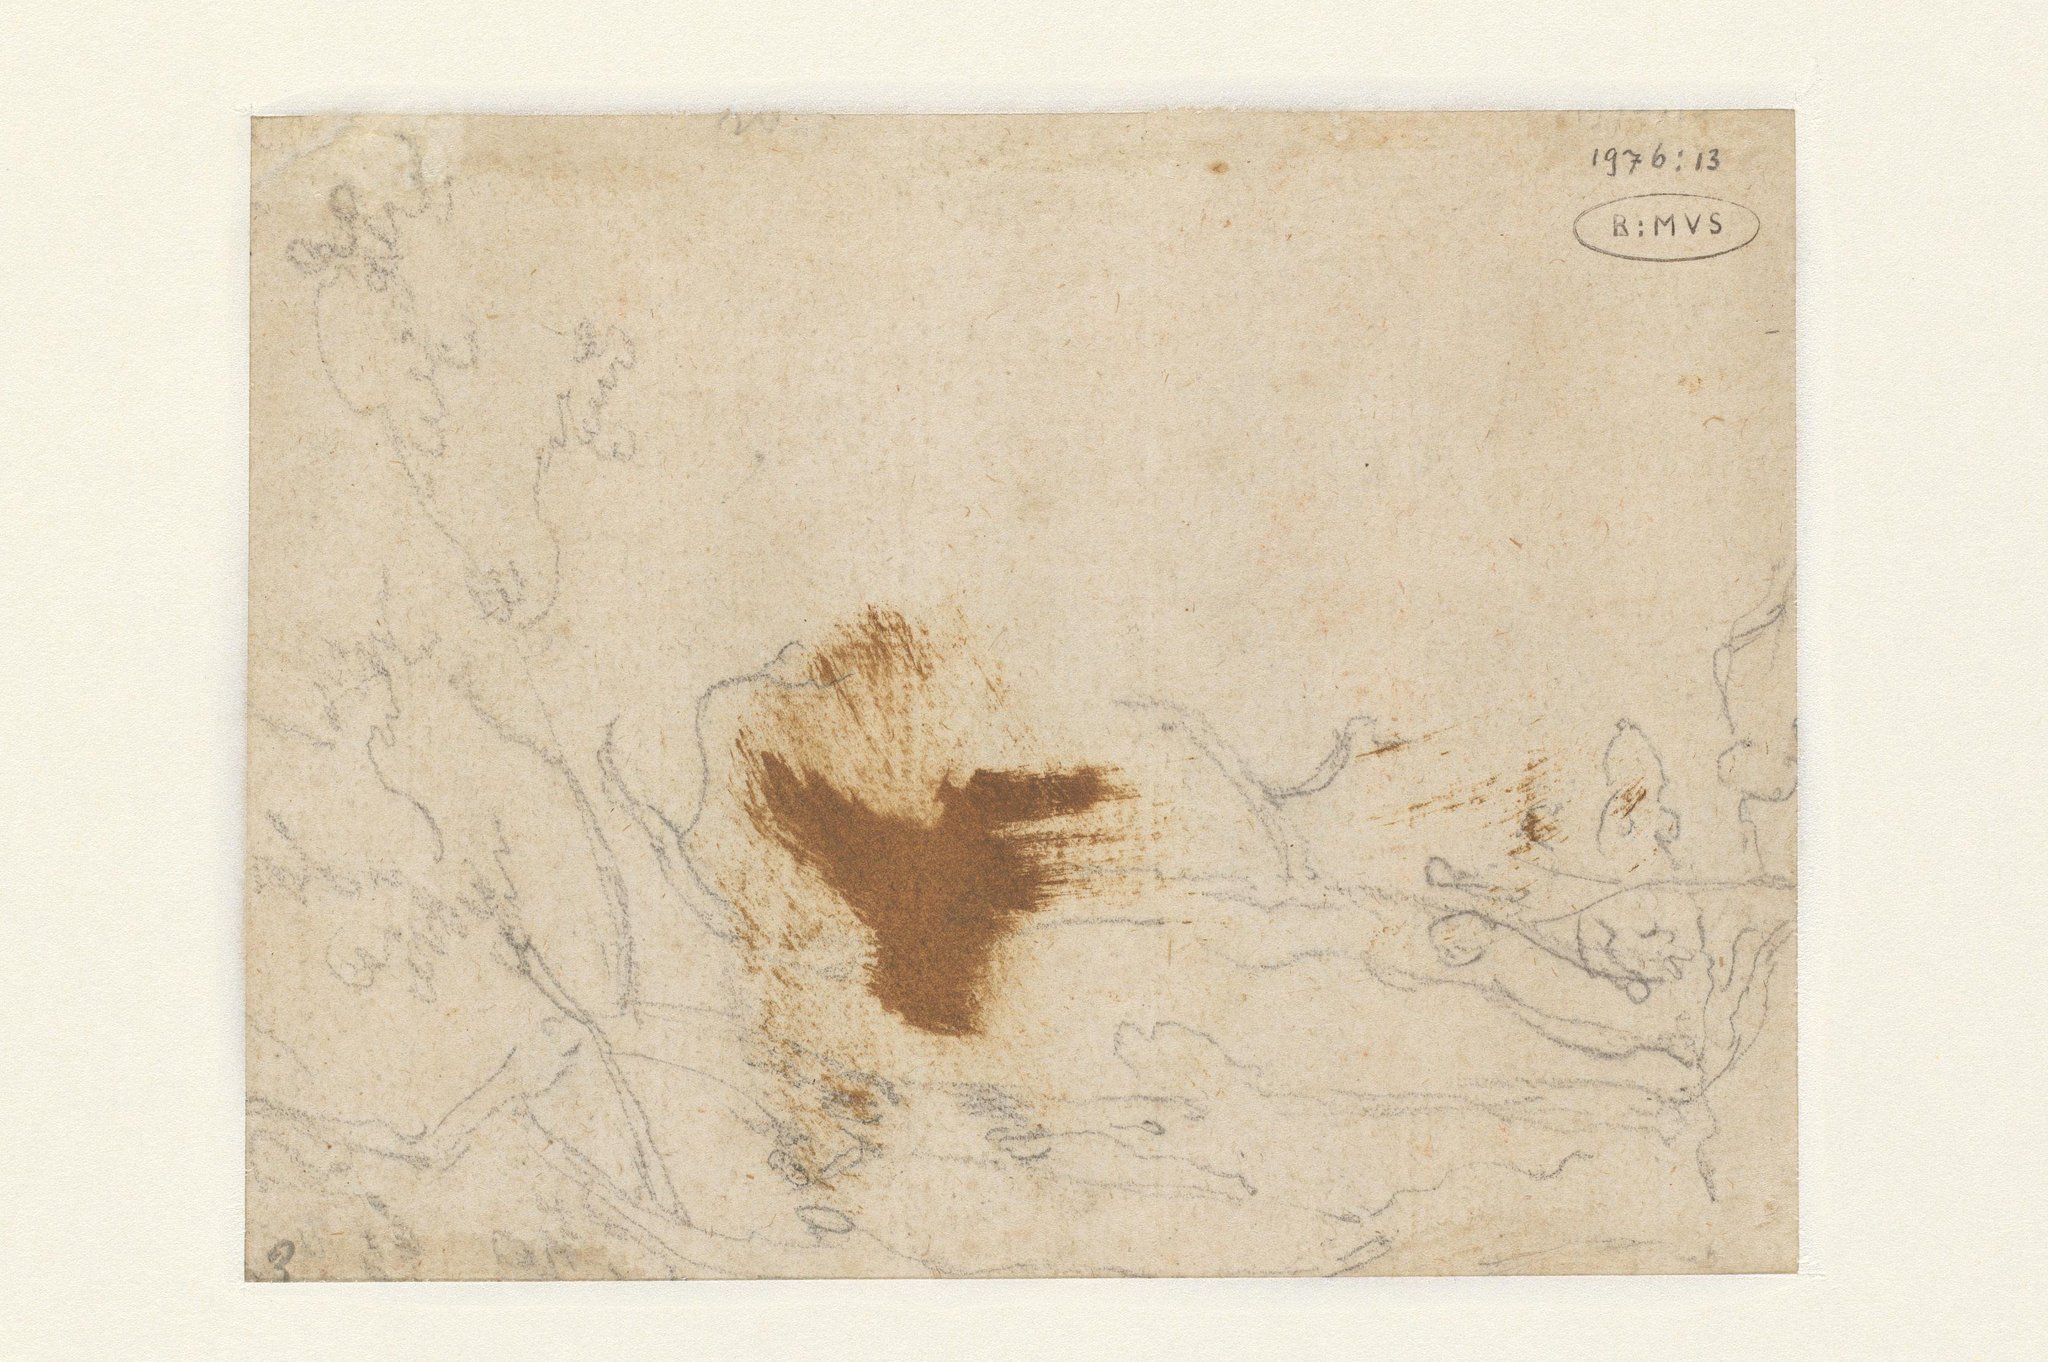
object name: drawing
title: Schets van bomen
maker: jan both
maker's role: draughtsman, painter, print maker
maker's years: 1618-1652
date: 1628-1652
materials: chalk, paper